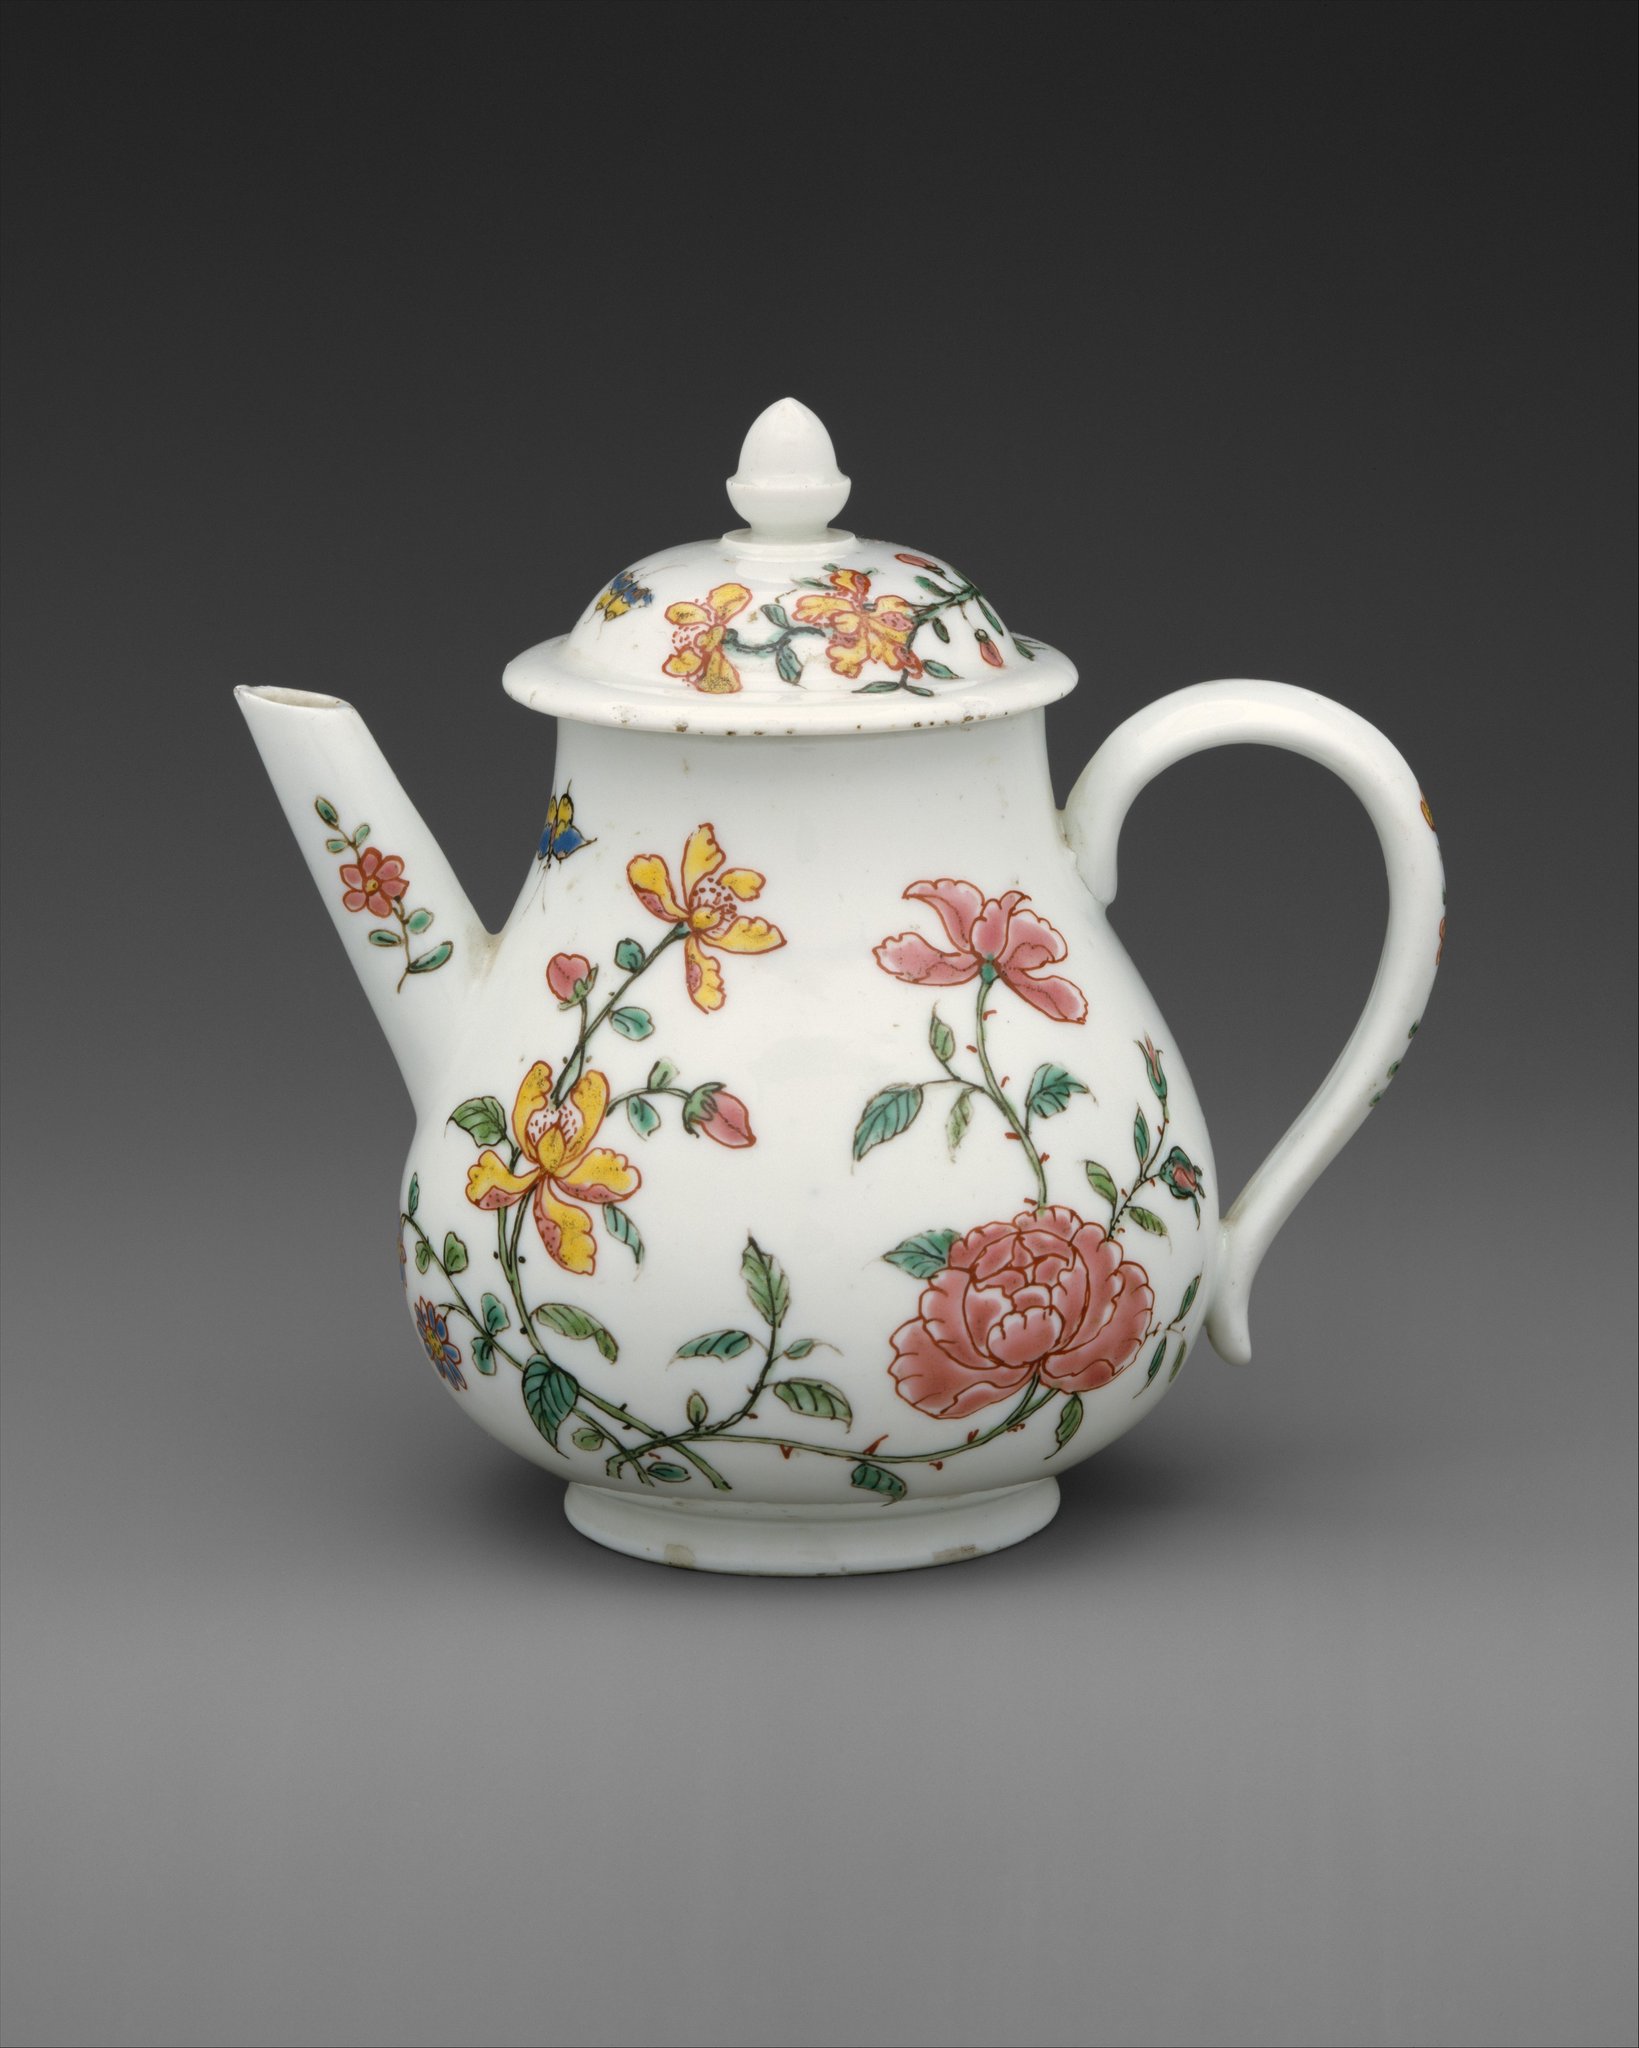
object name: teapot with cover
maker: meissen manufactory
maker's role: manufactory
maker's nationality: german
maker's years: 1710-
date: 1720-1730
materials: hard paste porcelain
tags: flowers